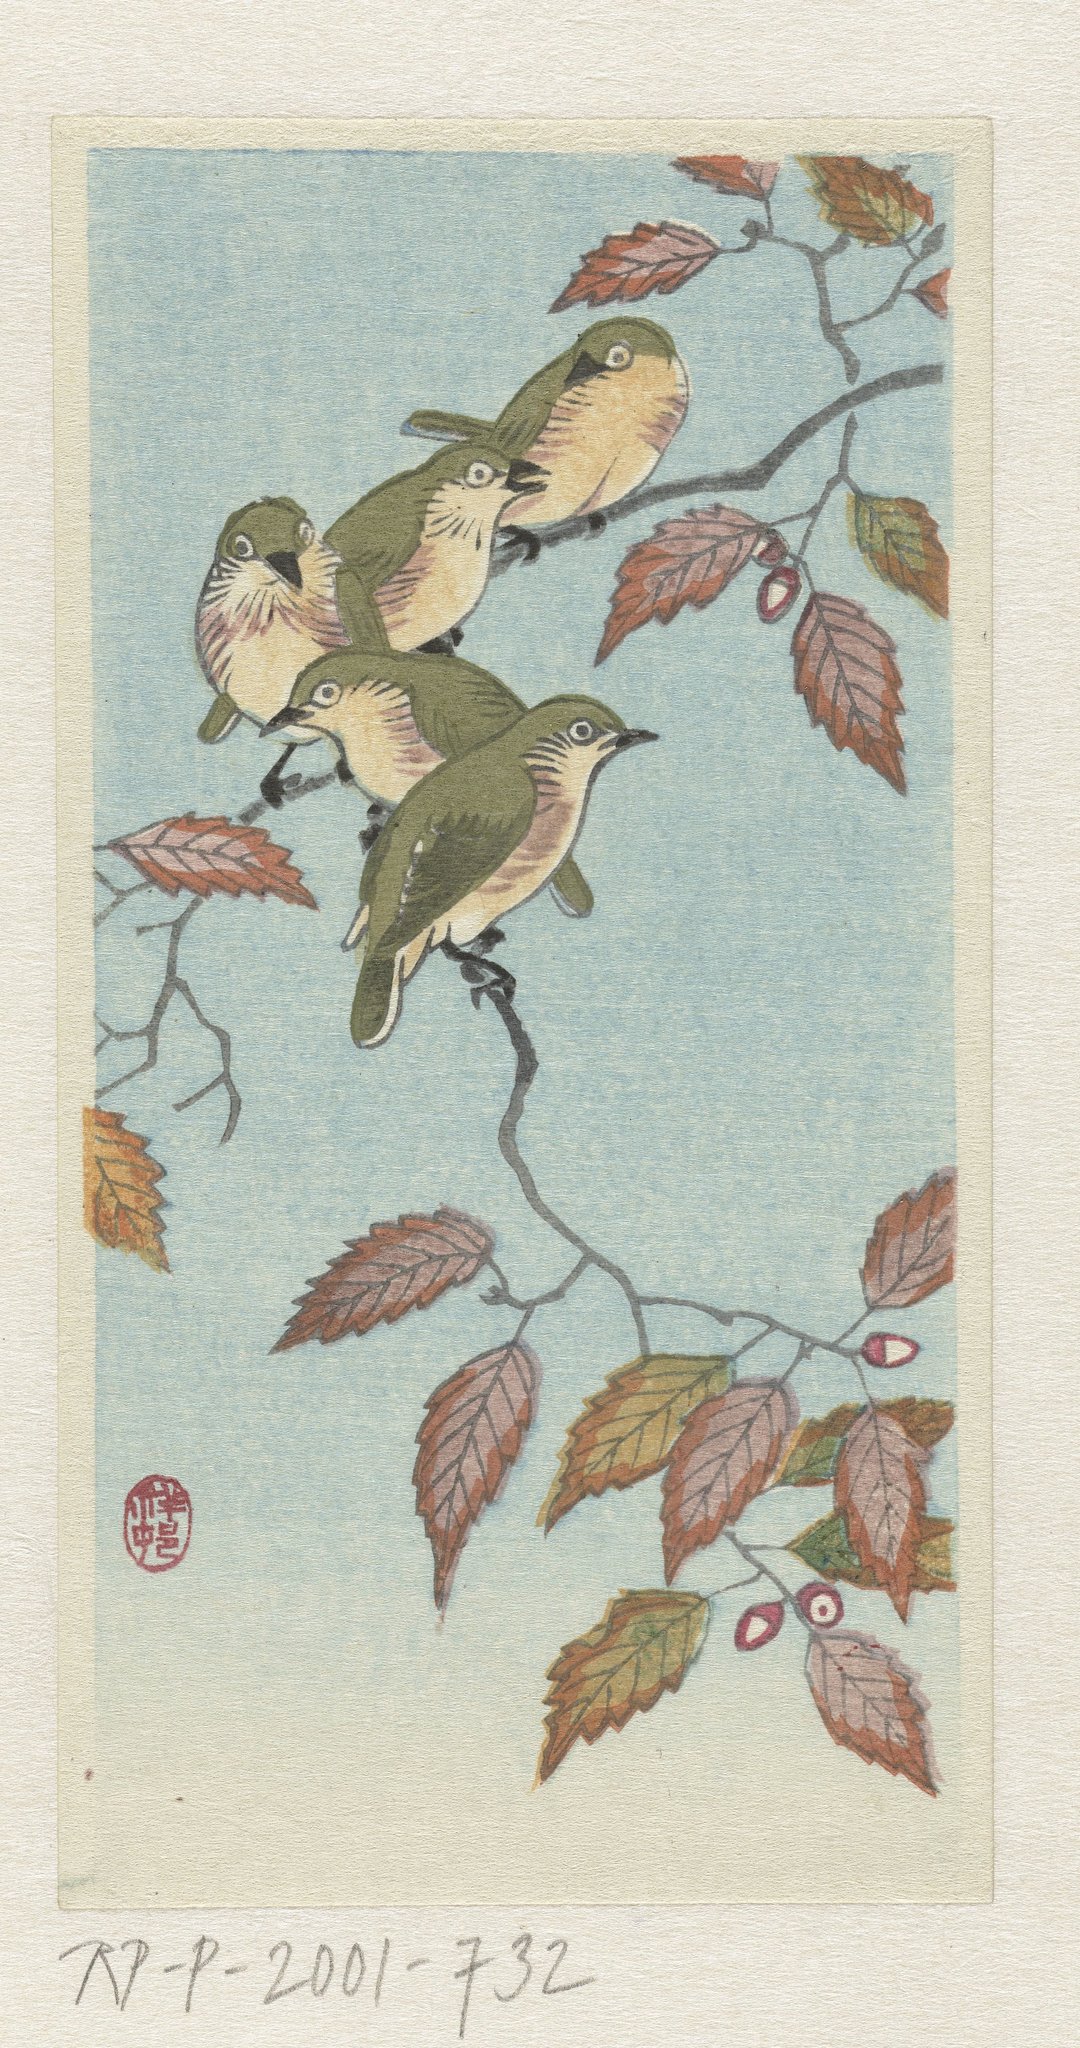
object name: print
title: Small Birds on a Twig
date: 1900-1936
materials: paper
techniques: woodcut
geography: japan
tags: plants; vegetation, birds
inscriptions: collector's mark: Lugt 2228